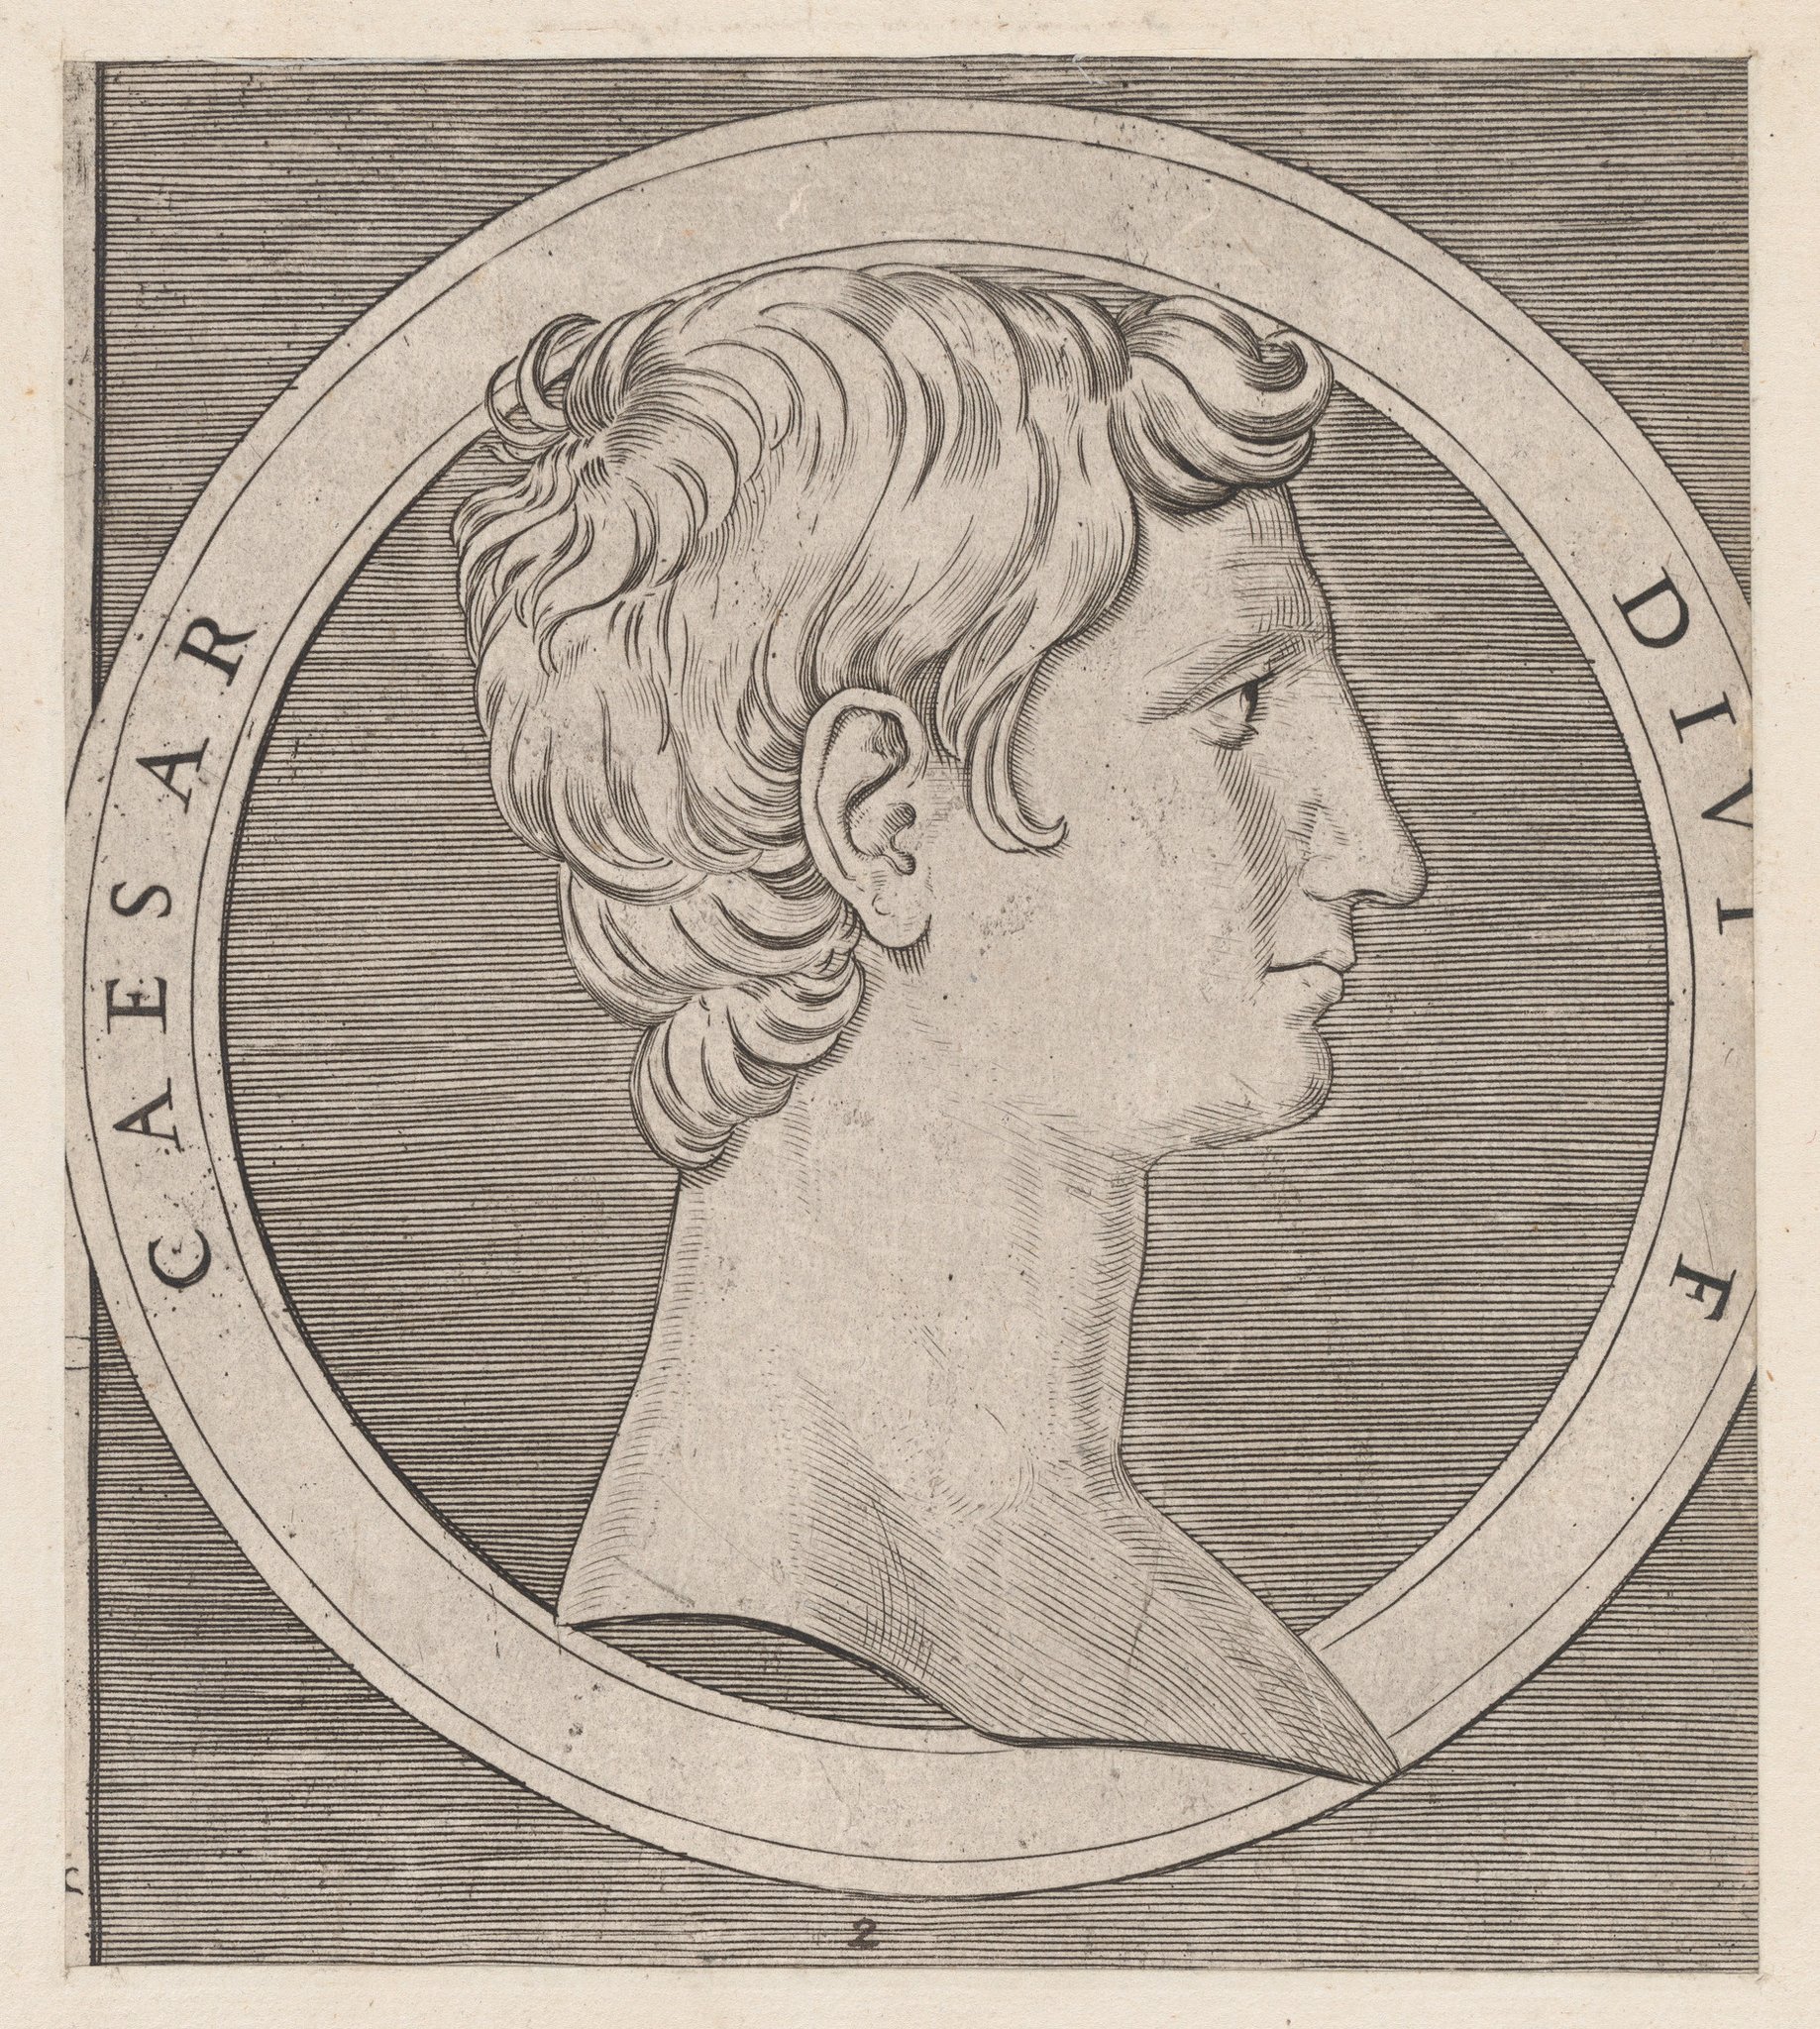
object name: print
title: Octavian (Augustus), from The Twelve Caesars, from "Speculum Romanae Magnificentiae"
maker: marcantonio raimondi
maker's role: artist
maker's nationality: italian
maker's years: 1475-1534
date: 1500-1534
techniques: engraving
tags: emperor augustus,profiles